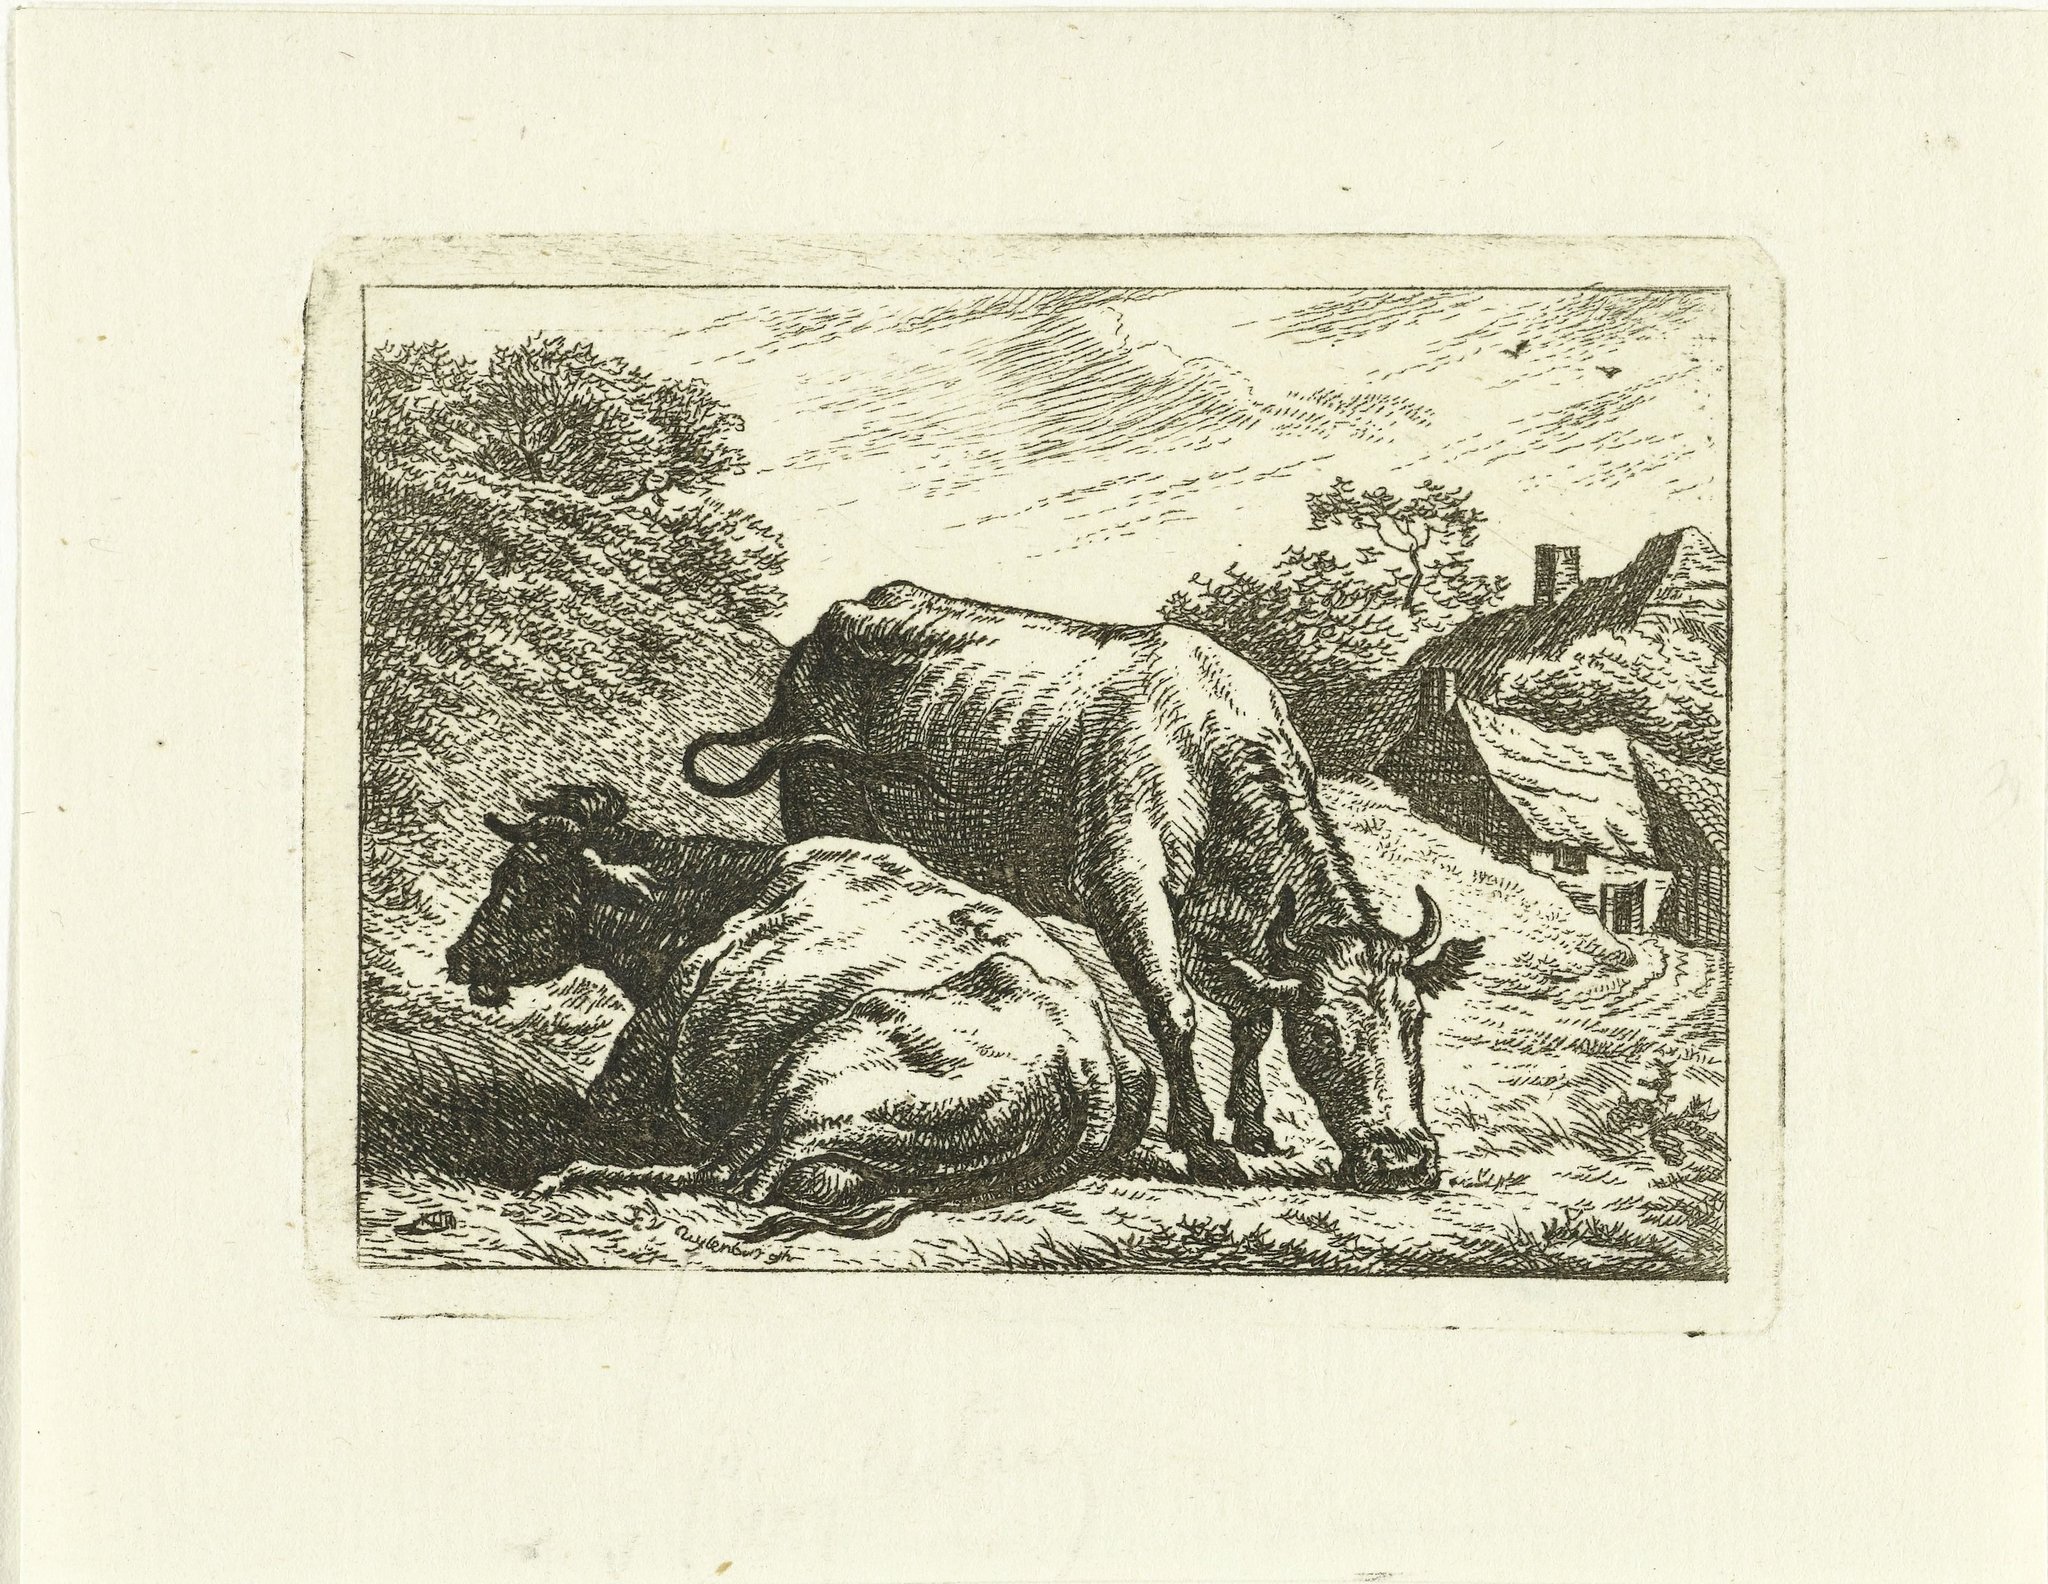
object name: print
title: Twee koeien langs weg bij boerderij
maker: johannes van cuylenburgh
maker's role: print maker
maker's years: 1793-1841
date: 1803-1841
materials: paper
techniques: etching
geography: netherlands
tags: cow, farm or solitary house in landscape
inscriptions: collector's mark: Lugt 2228